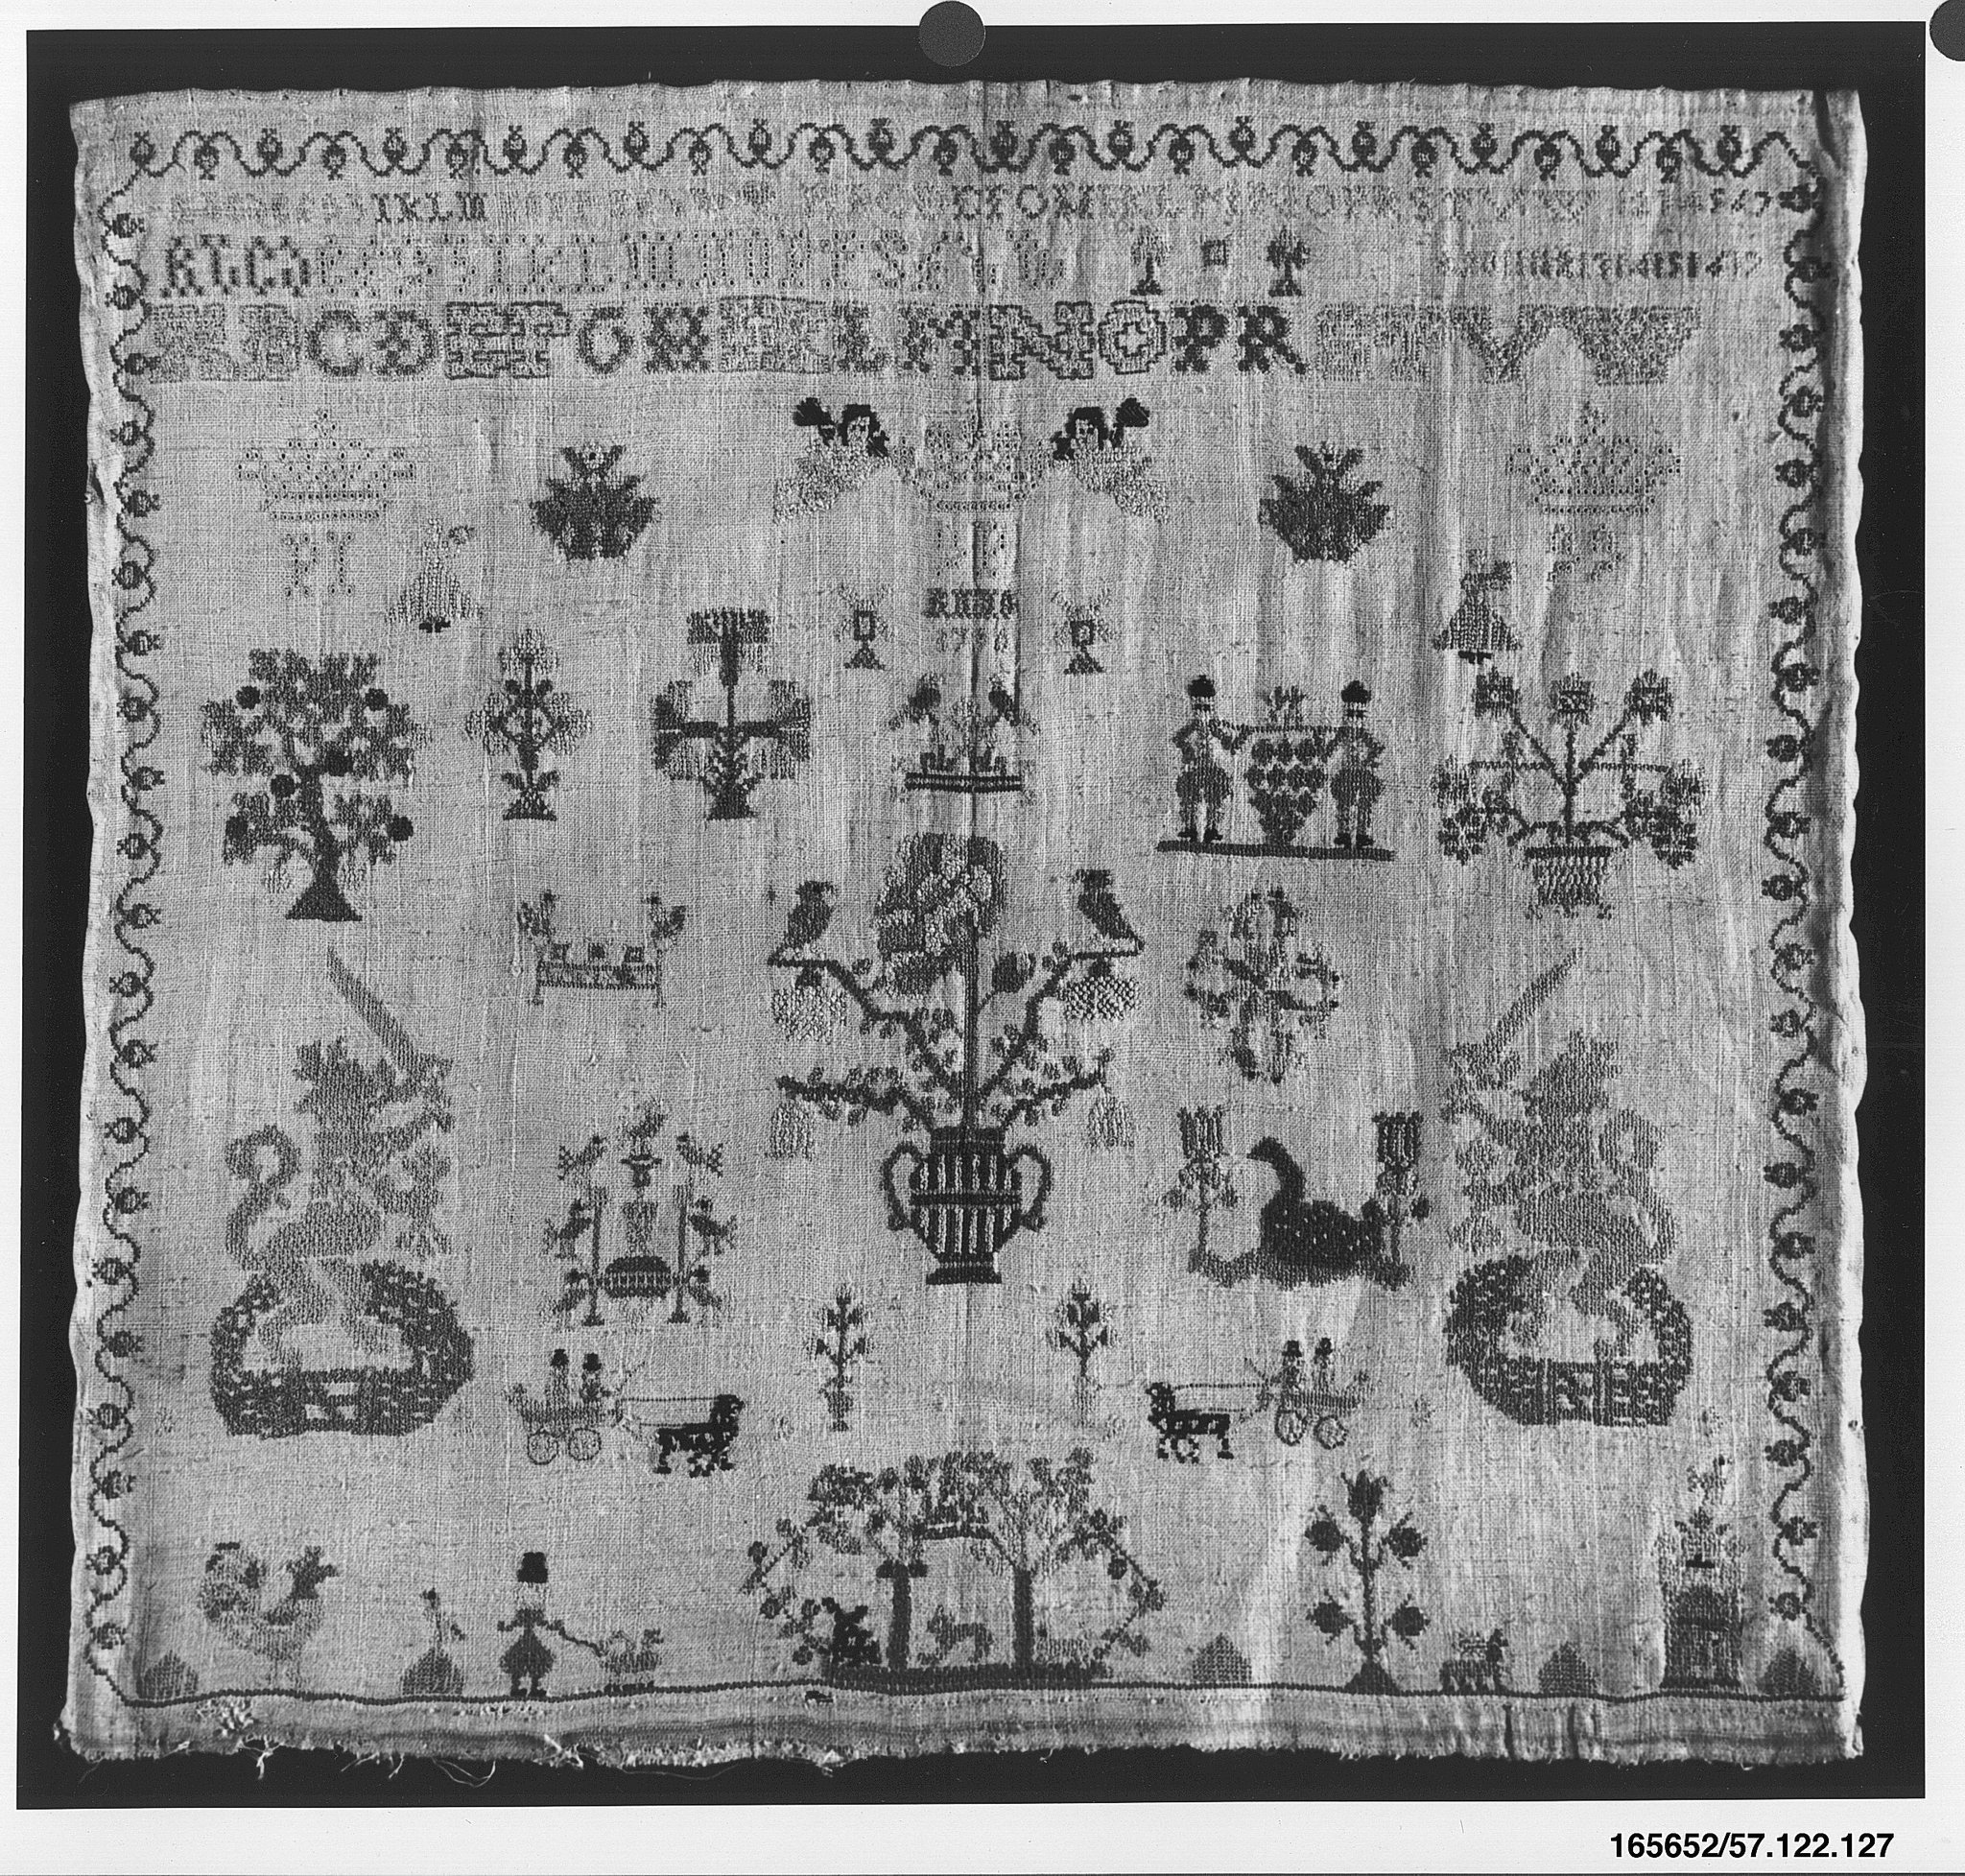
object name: sampler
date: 1790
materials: linen, silk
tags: birds,lions,flowers,carriages